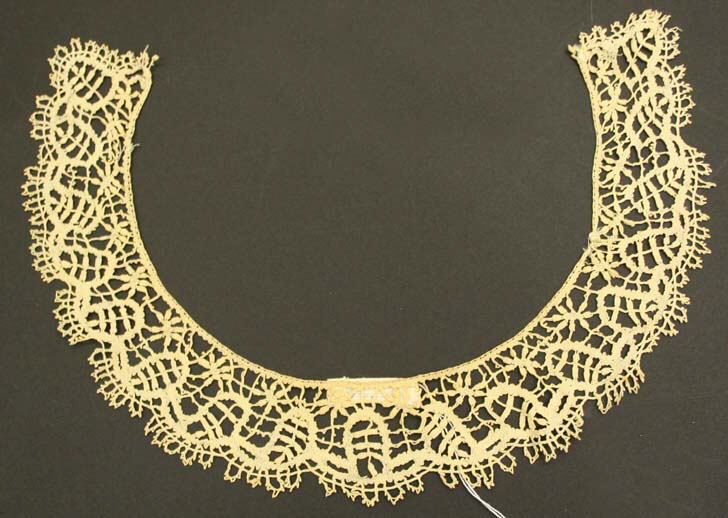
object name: collar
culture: american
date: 1848-1860